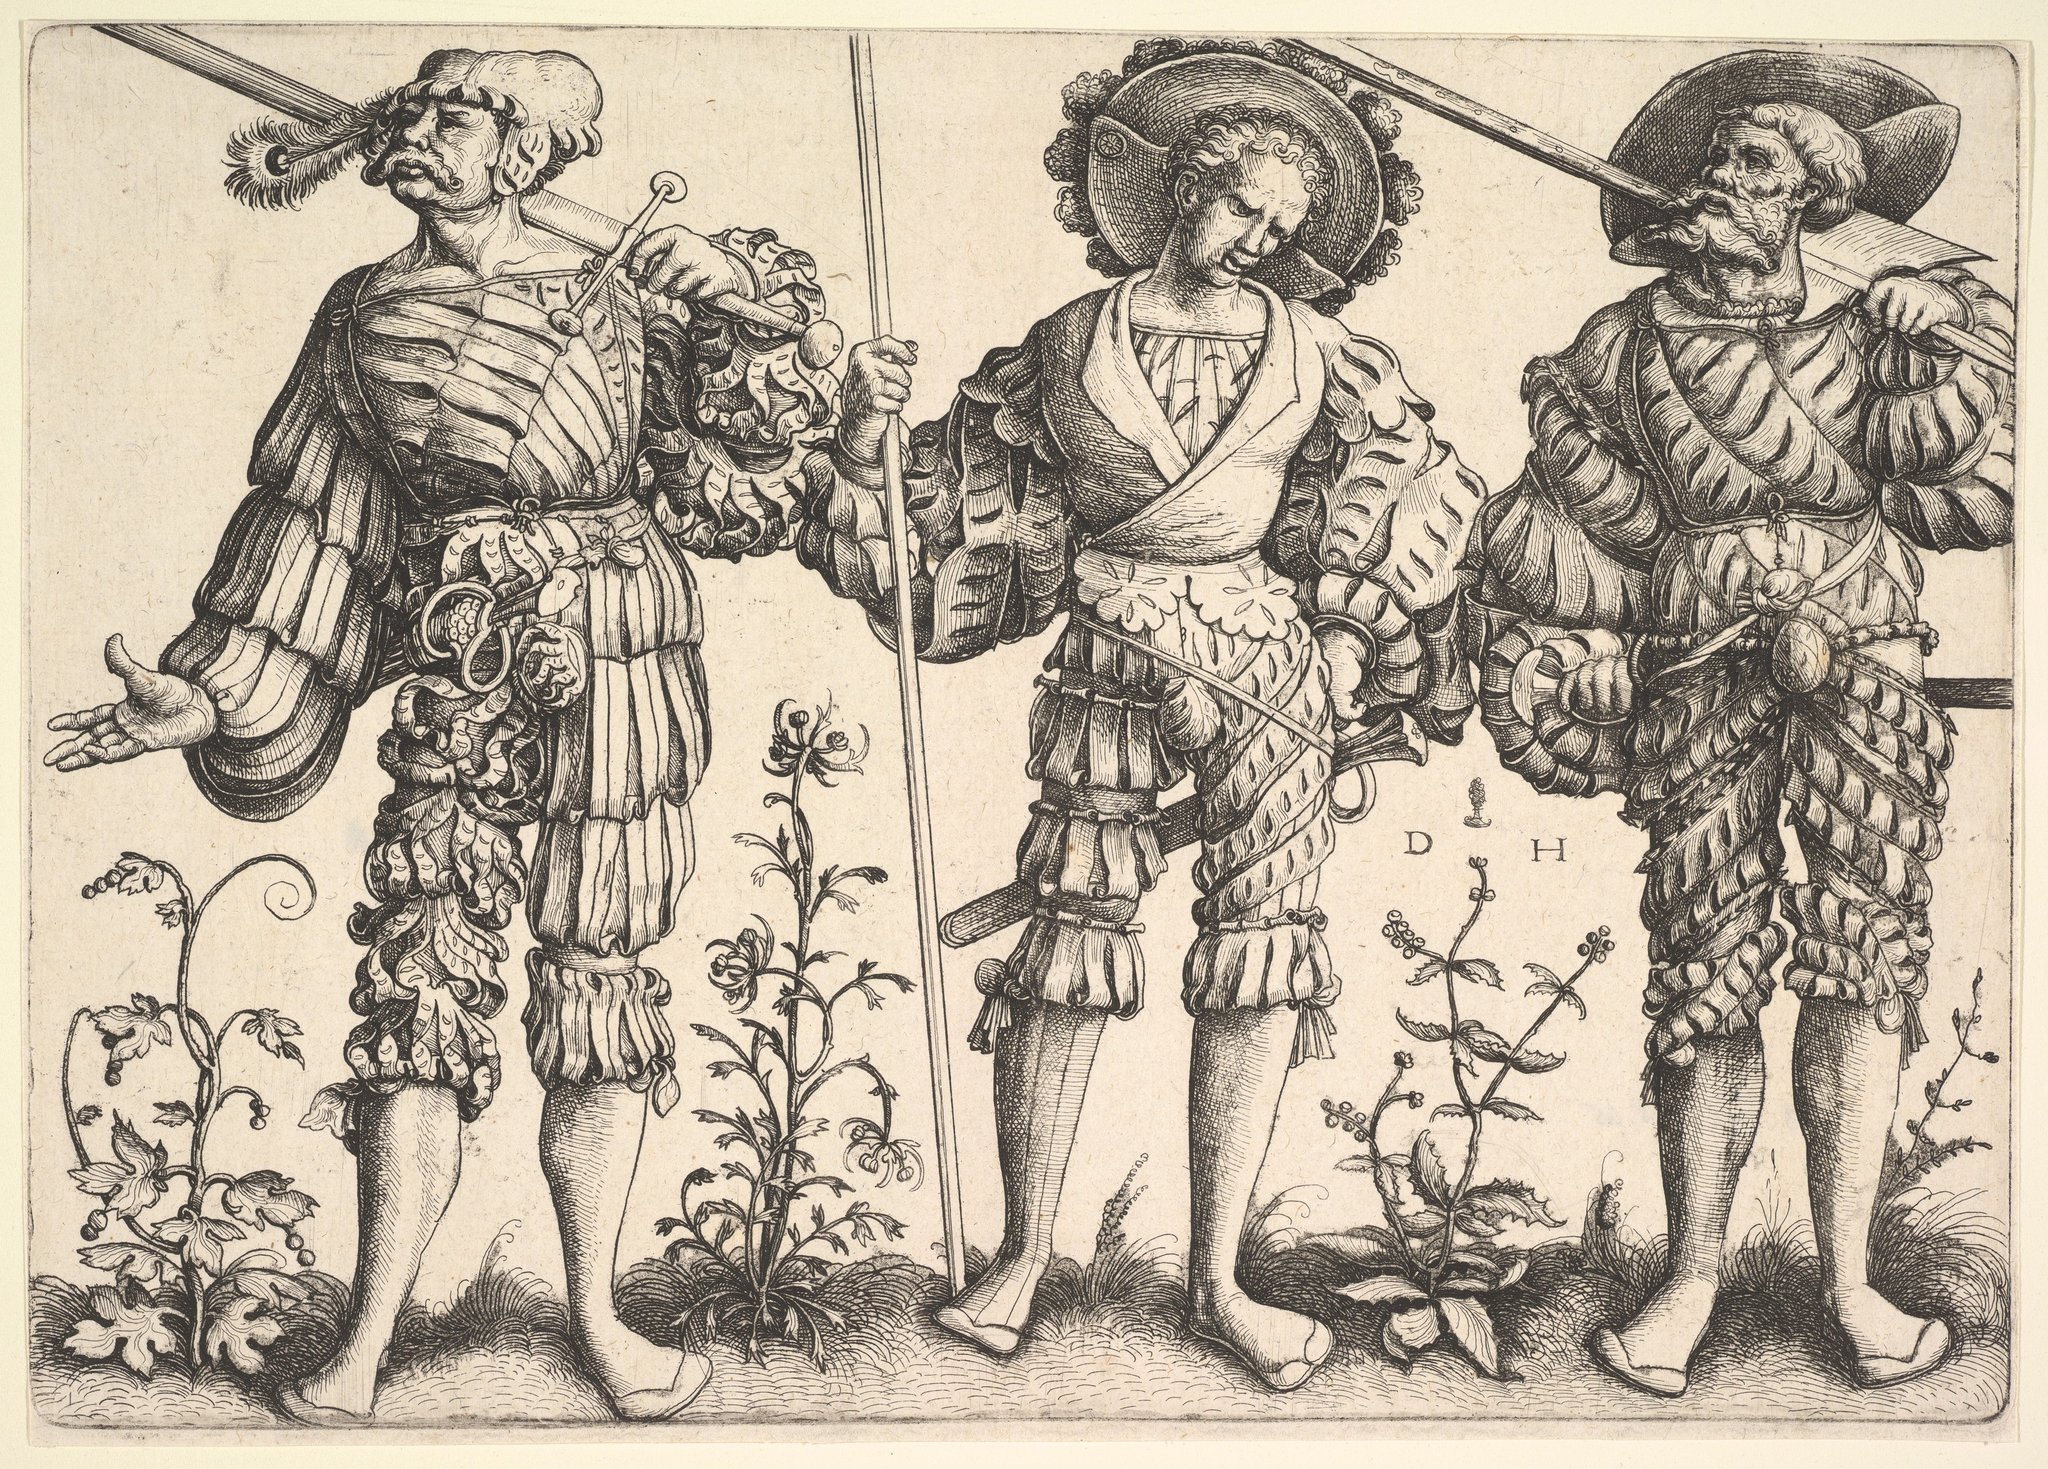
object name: print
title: Three German Soldiers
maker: daniel hopfer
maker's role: artist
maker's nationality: german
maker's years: 1470-1536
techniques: etching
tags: soldiers,swords,men,plants